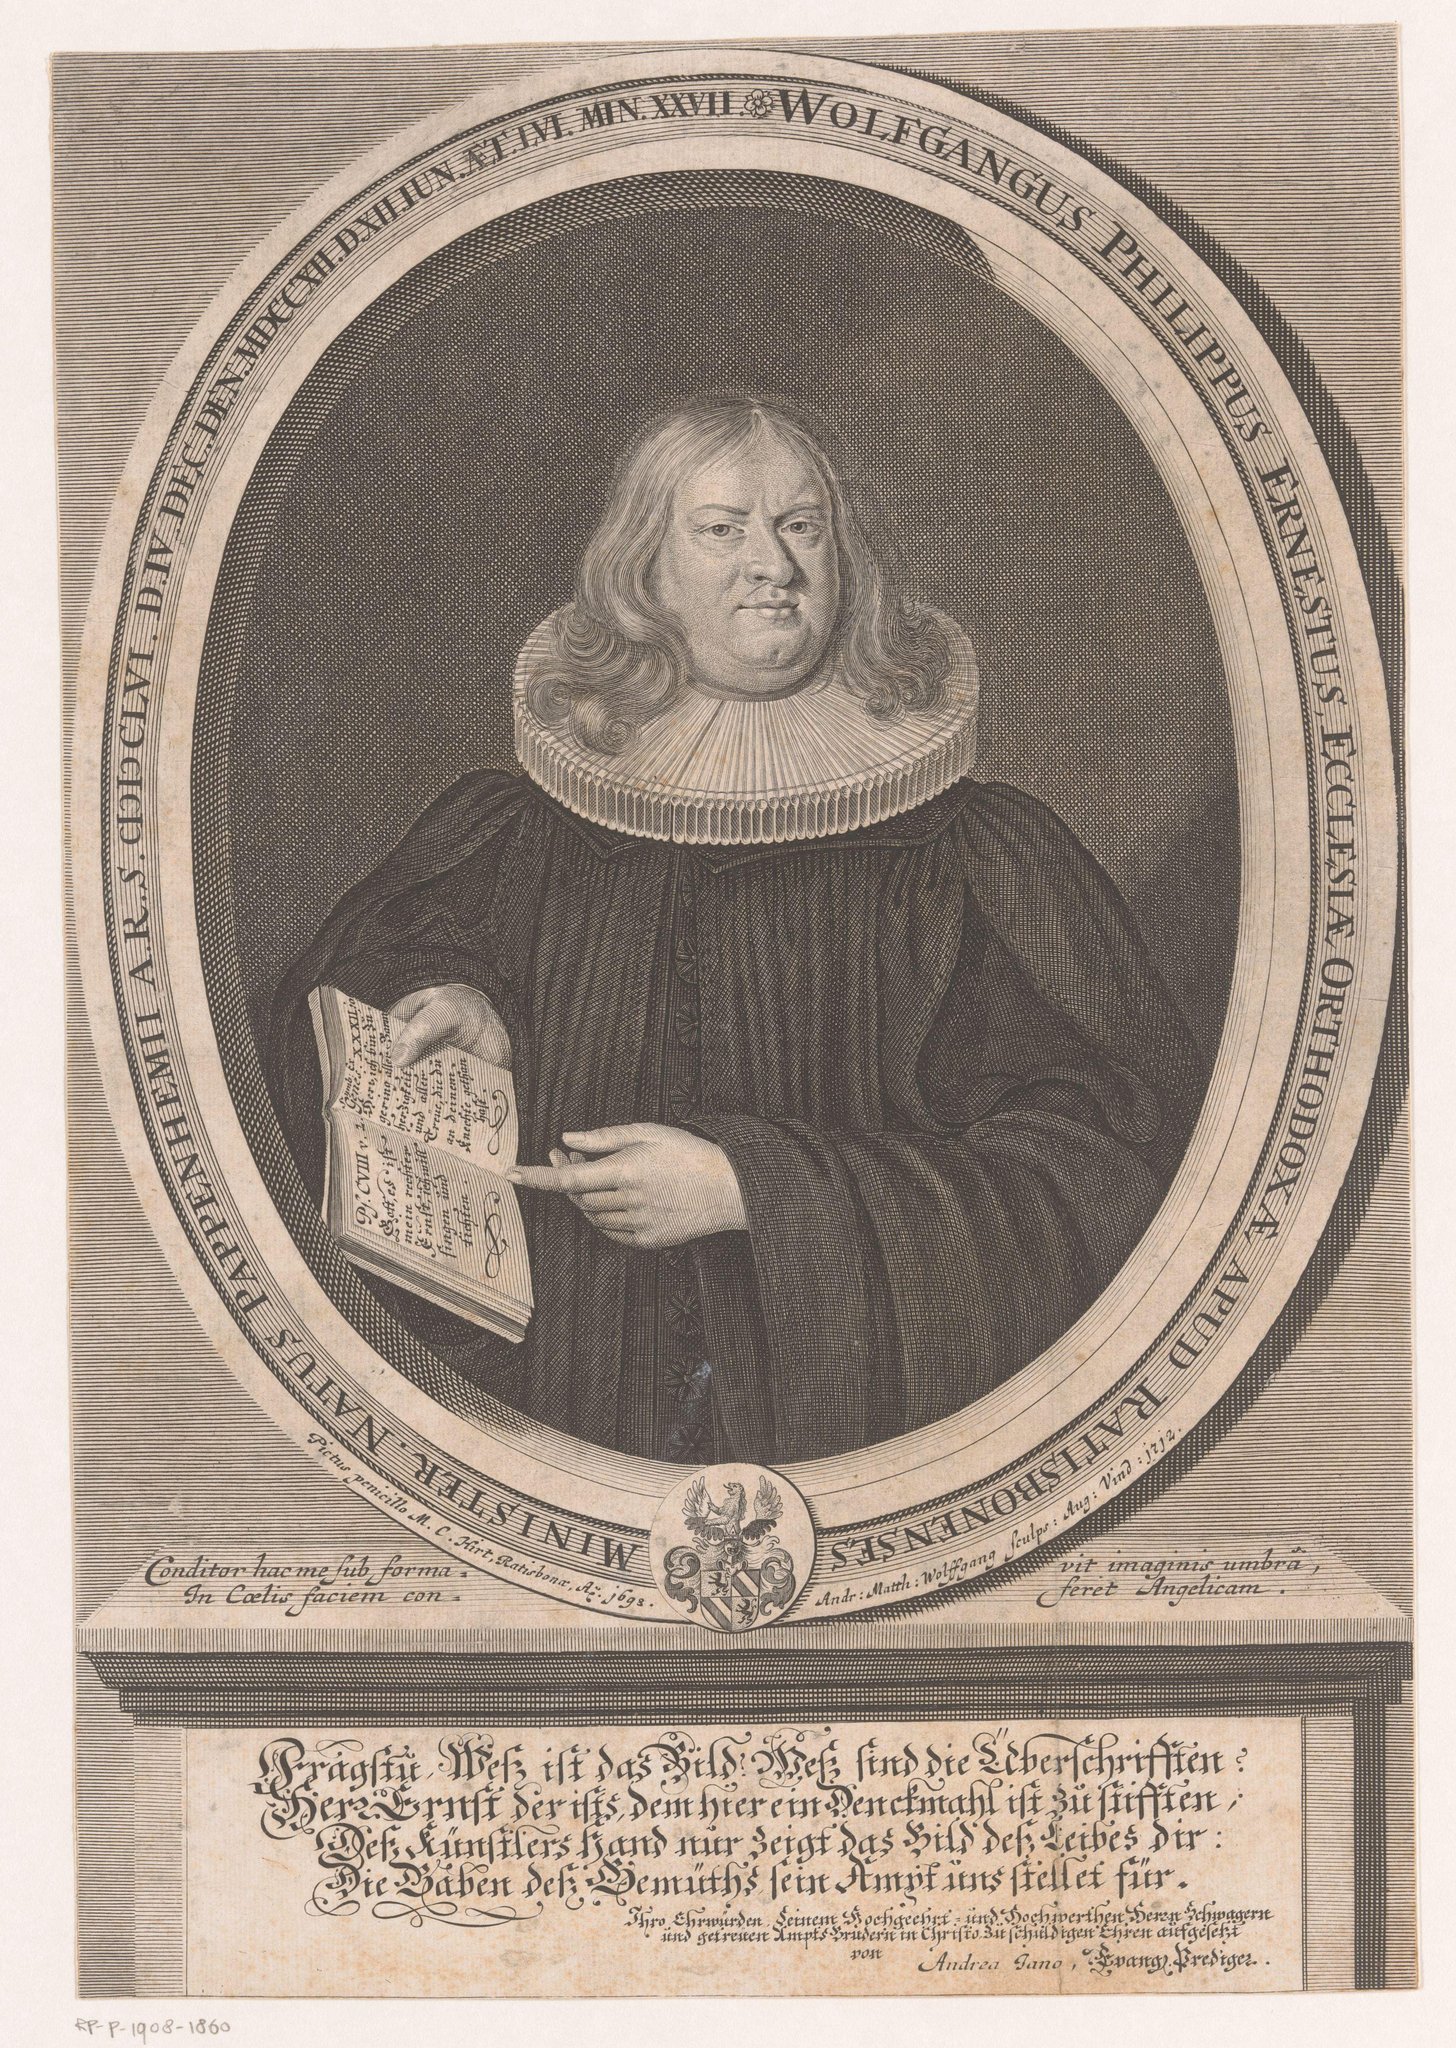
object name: print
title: Portret van Wolfgang Philipp Ernst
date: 1712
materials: paper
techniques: engraving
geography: augsburg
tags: wolfgang philipp ernst, historical persons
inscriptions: collector's mark: Lugt 2228, collector's mark: Lugt 9